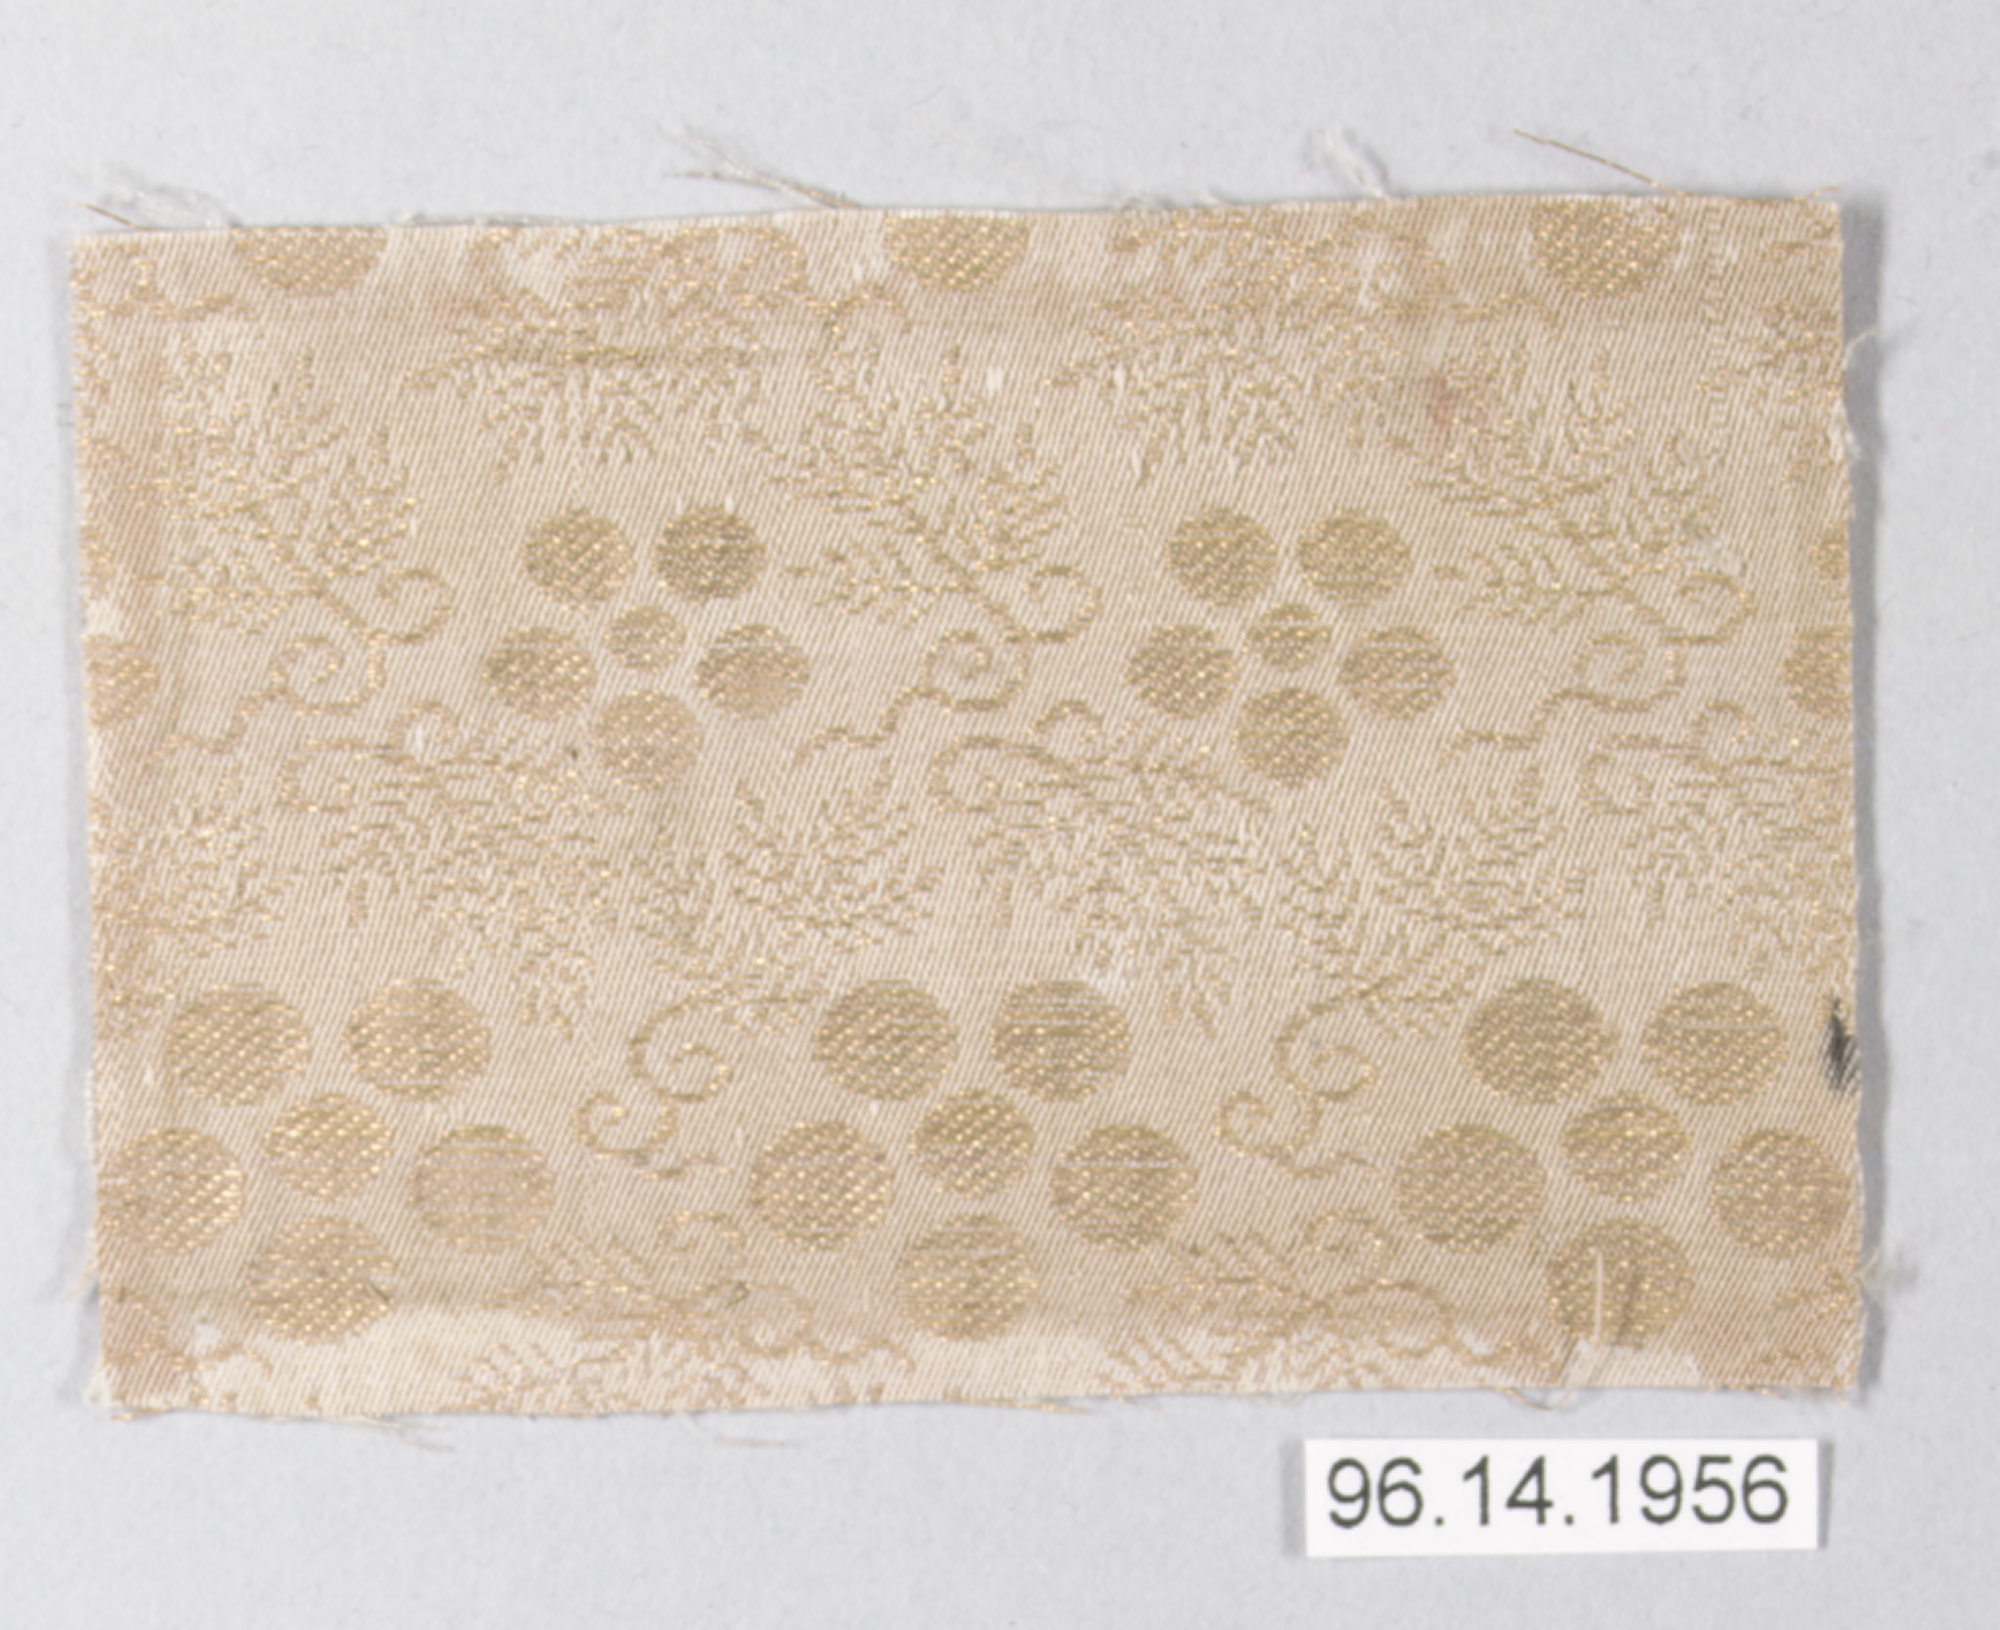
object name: piece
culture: japanese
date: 1801-1900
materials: metal thread, silk